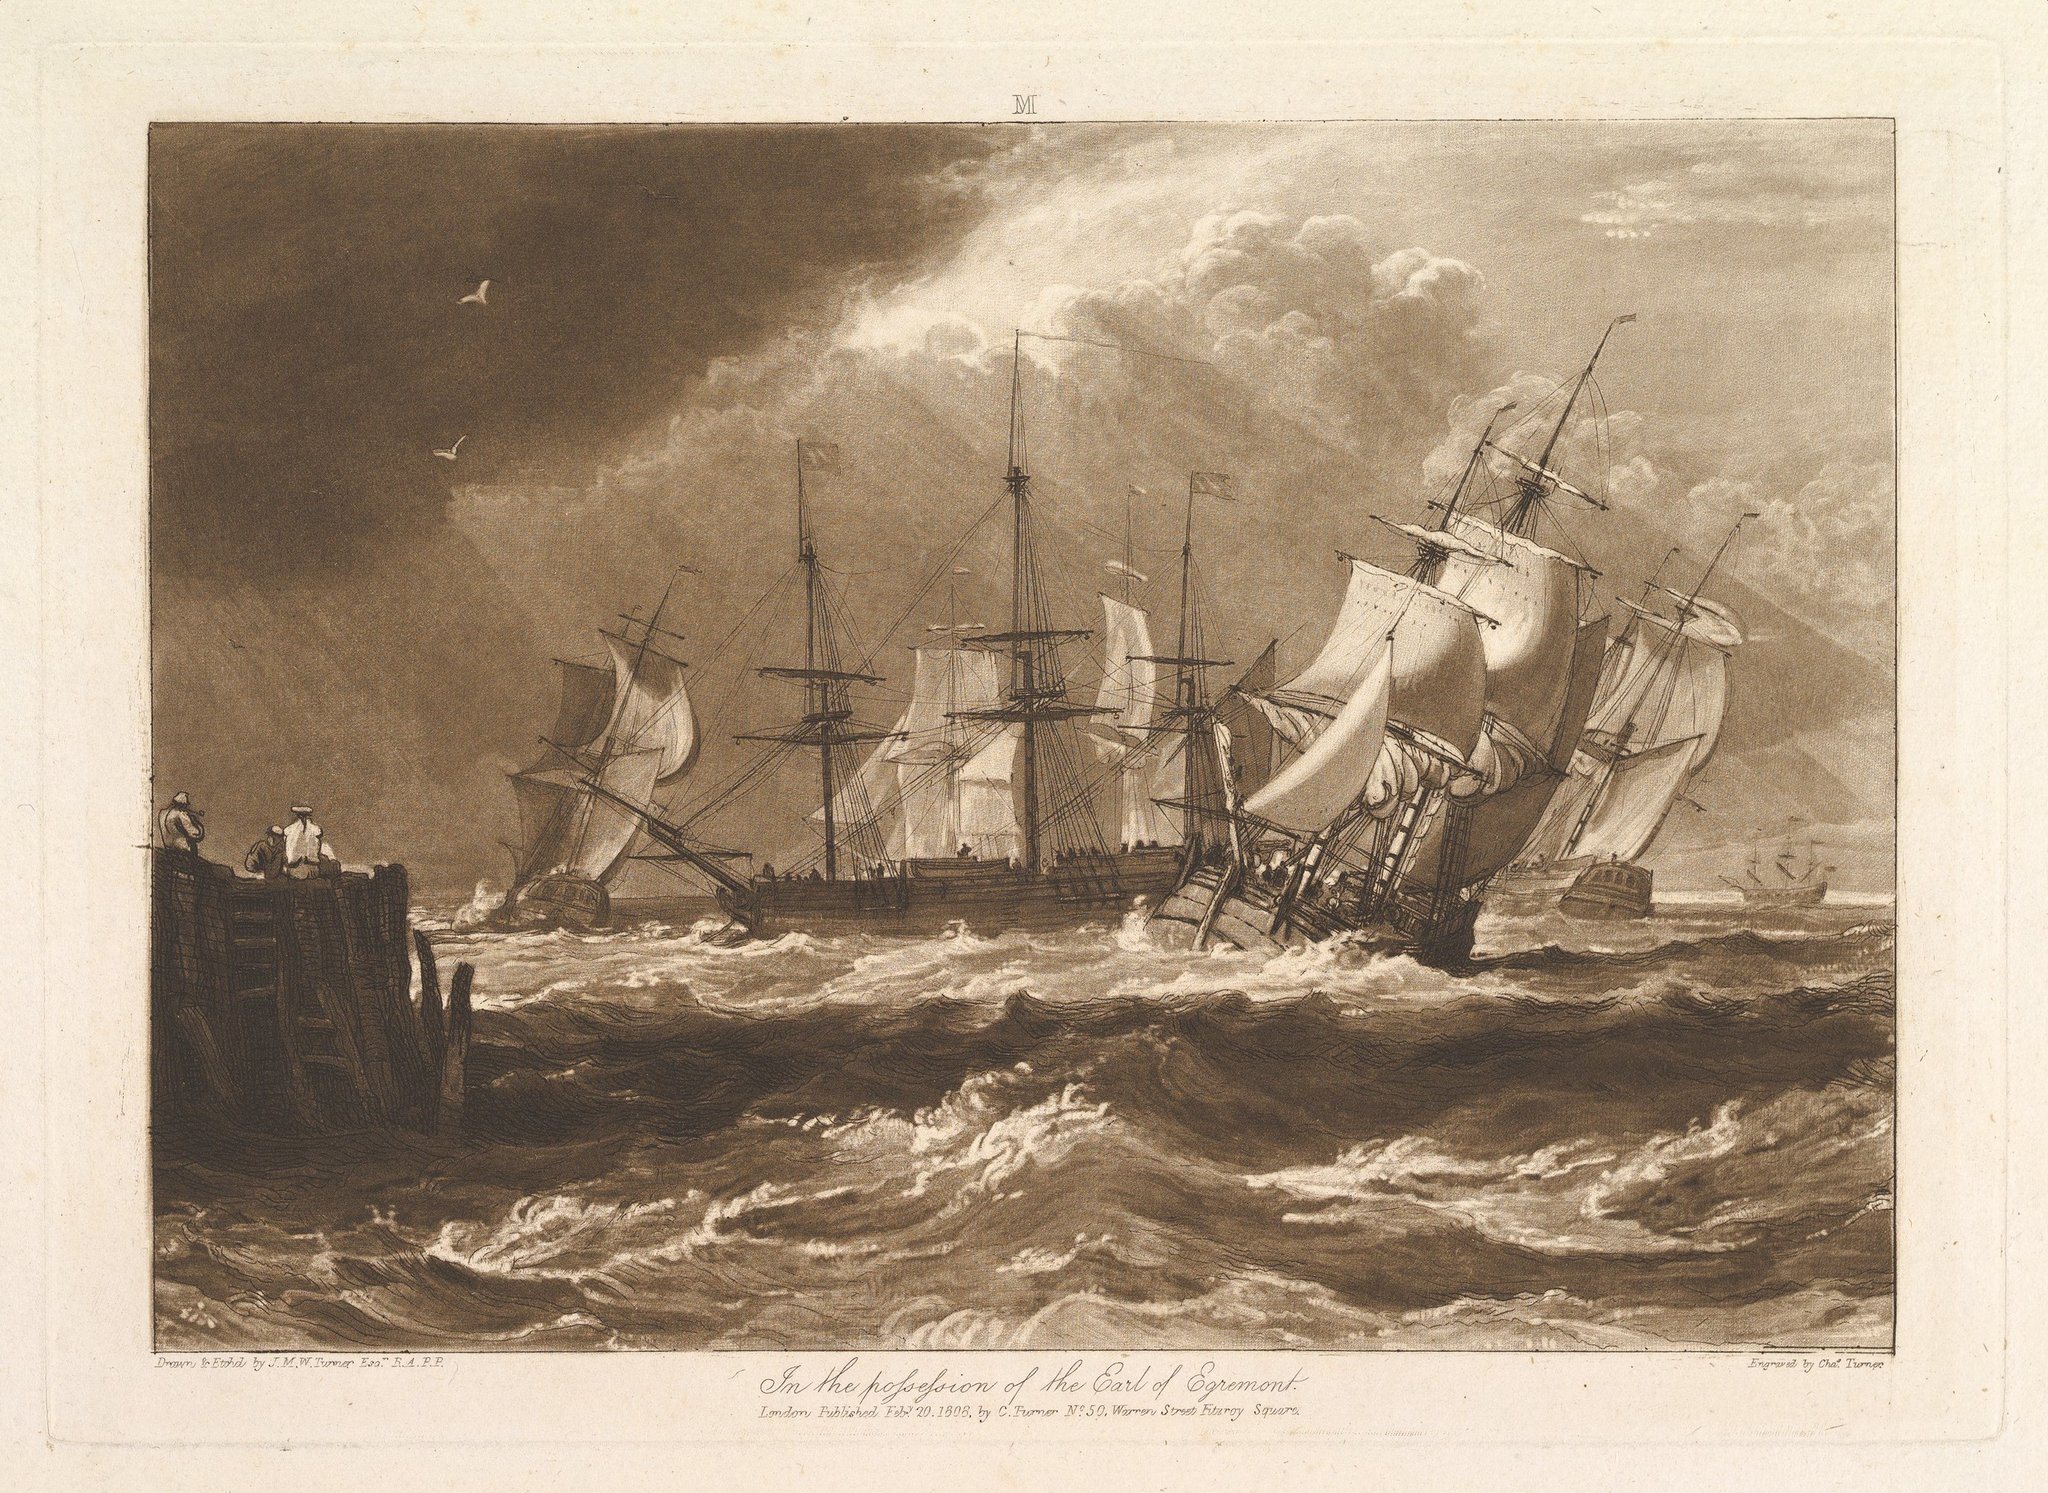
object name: print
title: Ships in a Breeze, part II, plate 10 from "Liber Studiorum"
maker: joseph mallord william turner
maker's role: artist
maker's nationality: british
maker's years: 1775-1851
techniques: etching, mezzotint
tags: ships